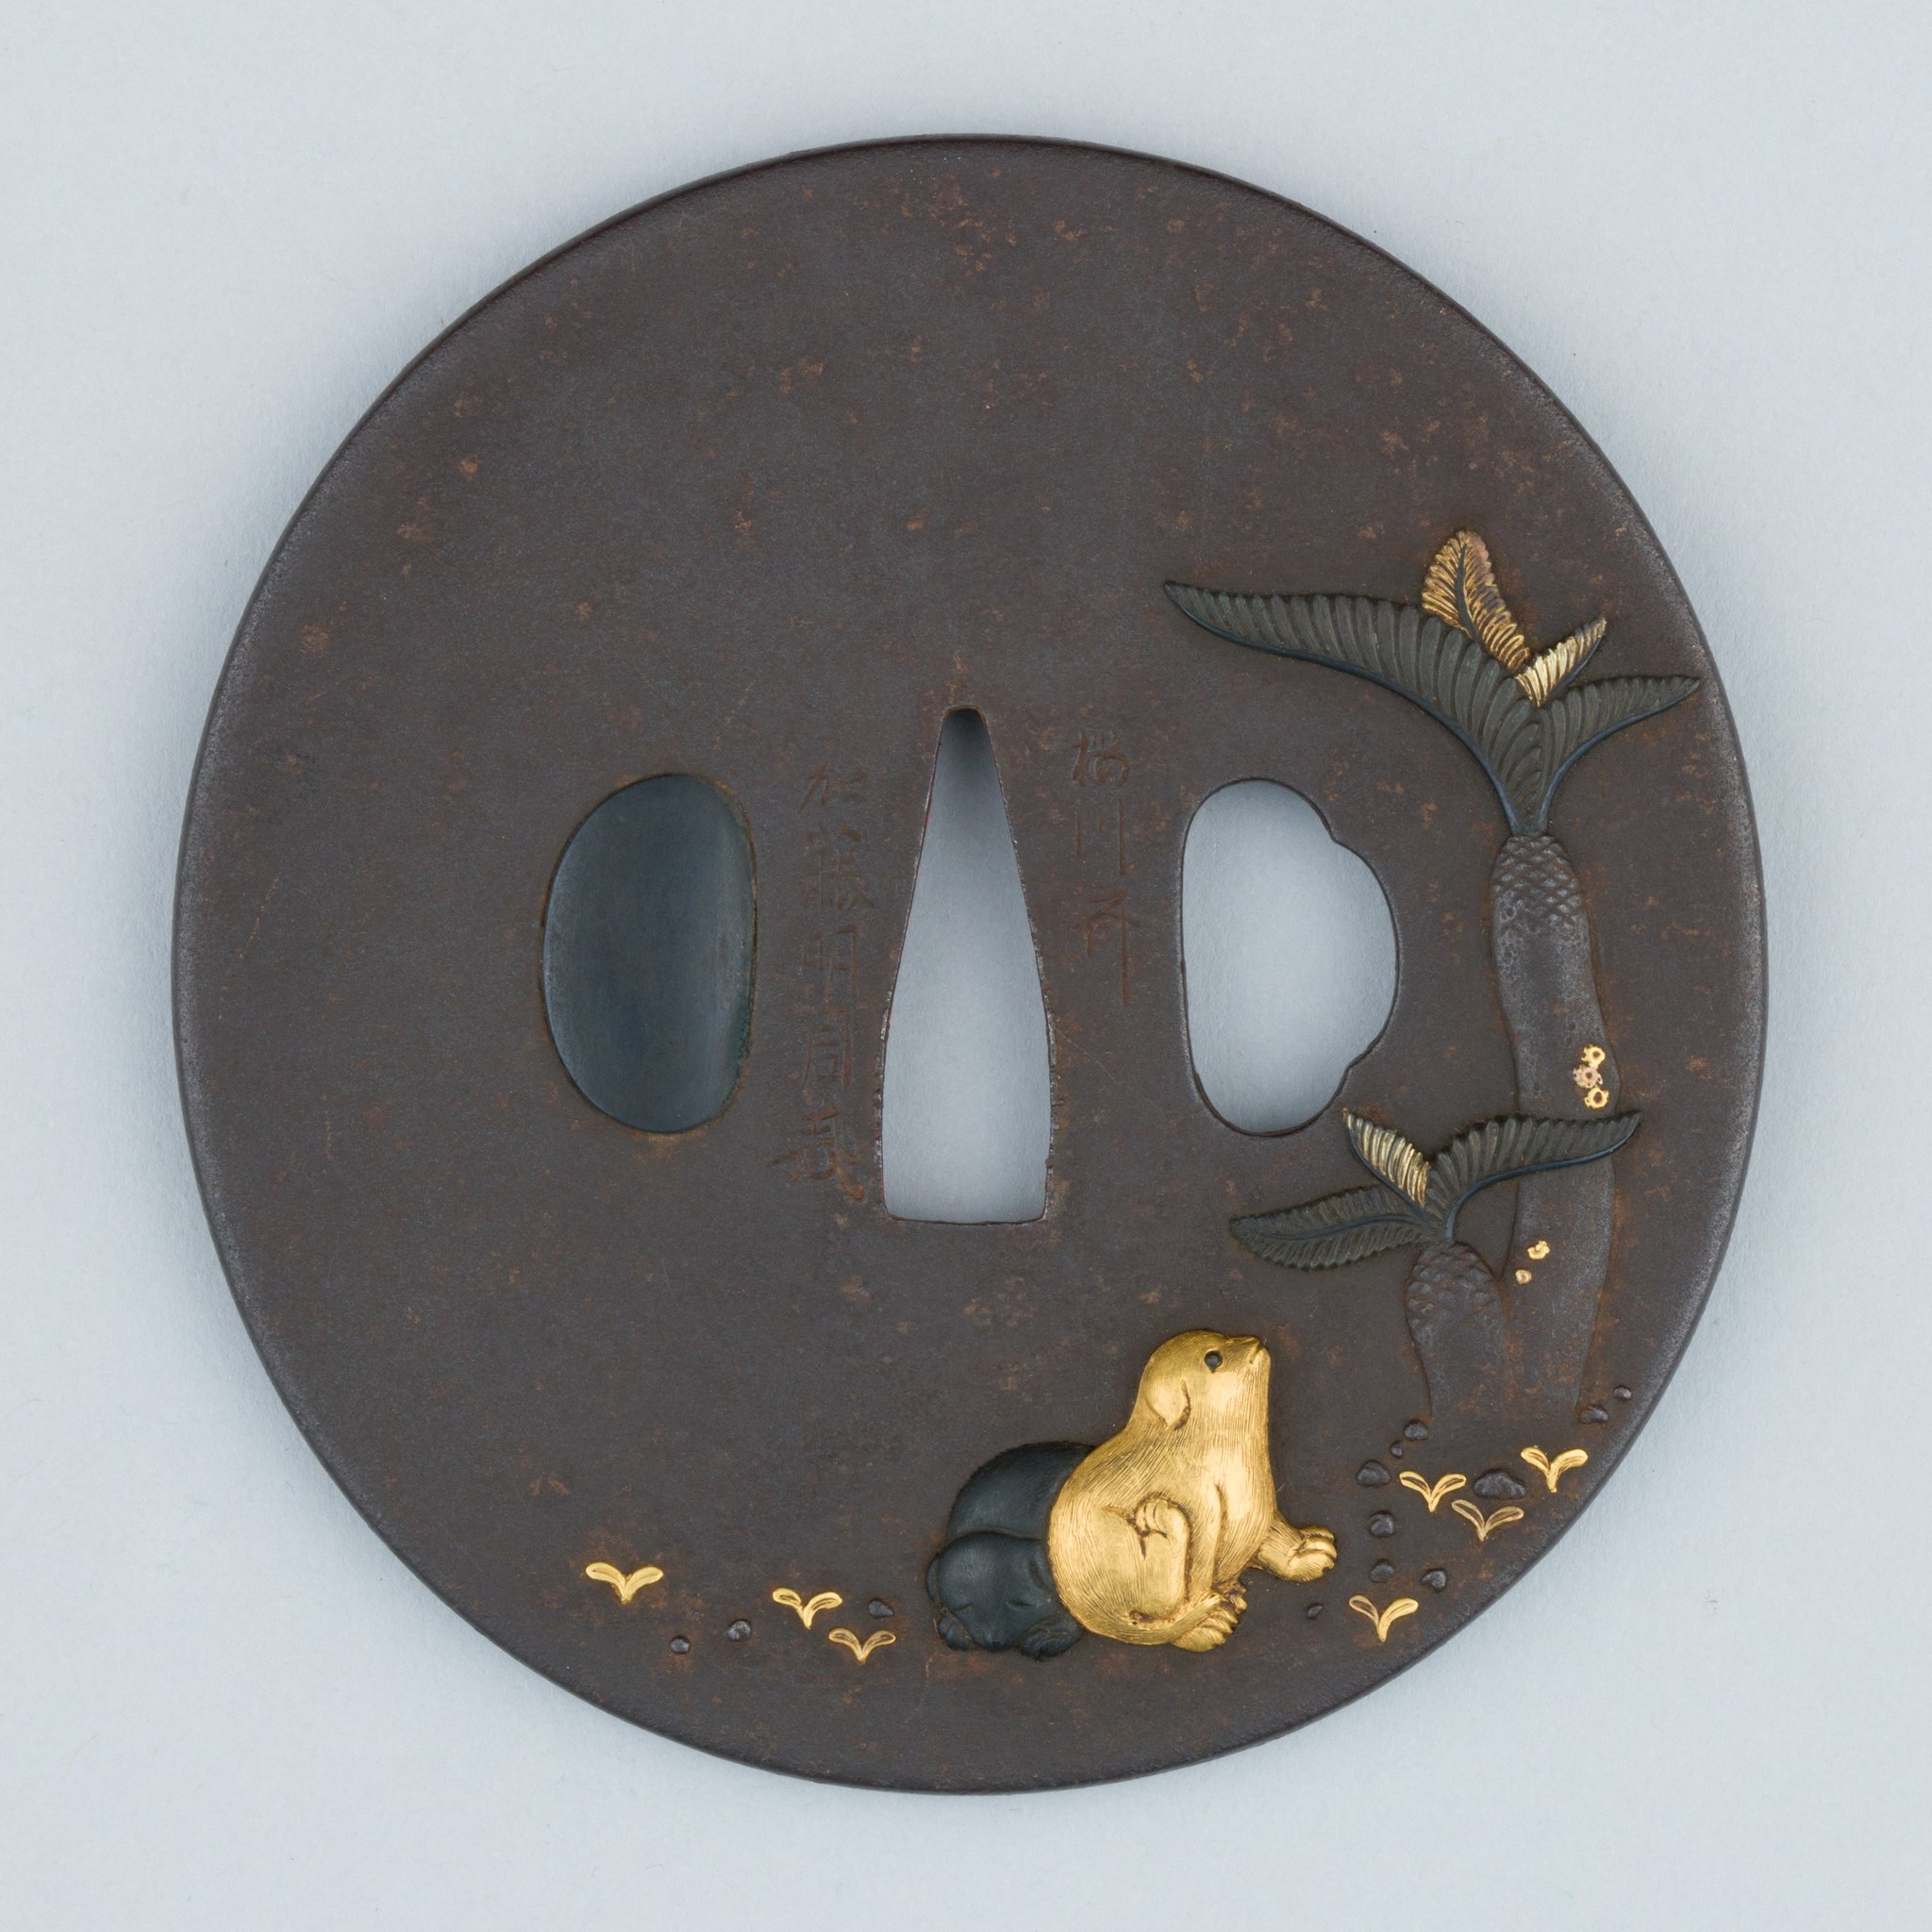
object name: sword guard tsuba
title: Sword Guard (Tsuba)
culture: japanese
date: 1615-1868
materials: copper, gold alloy, gold, iron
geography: japan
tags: animals